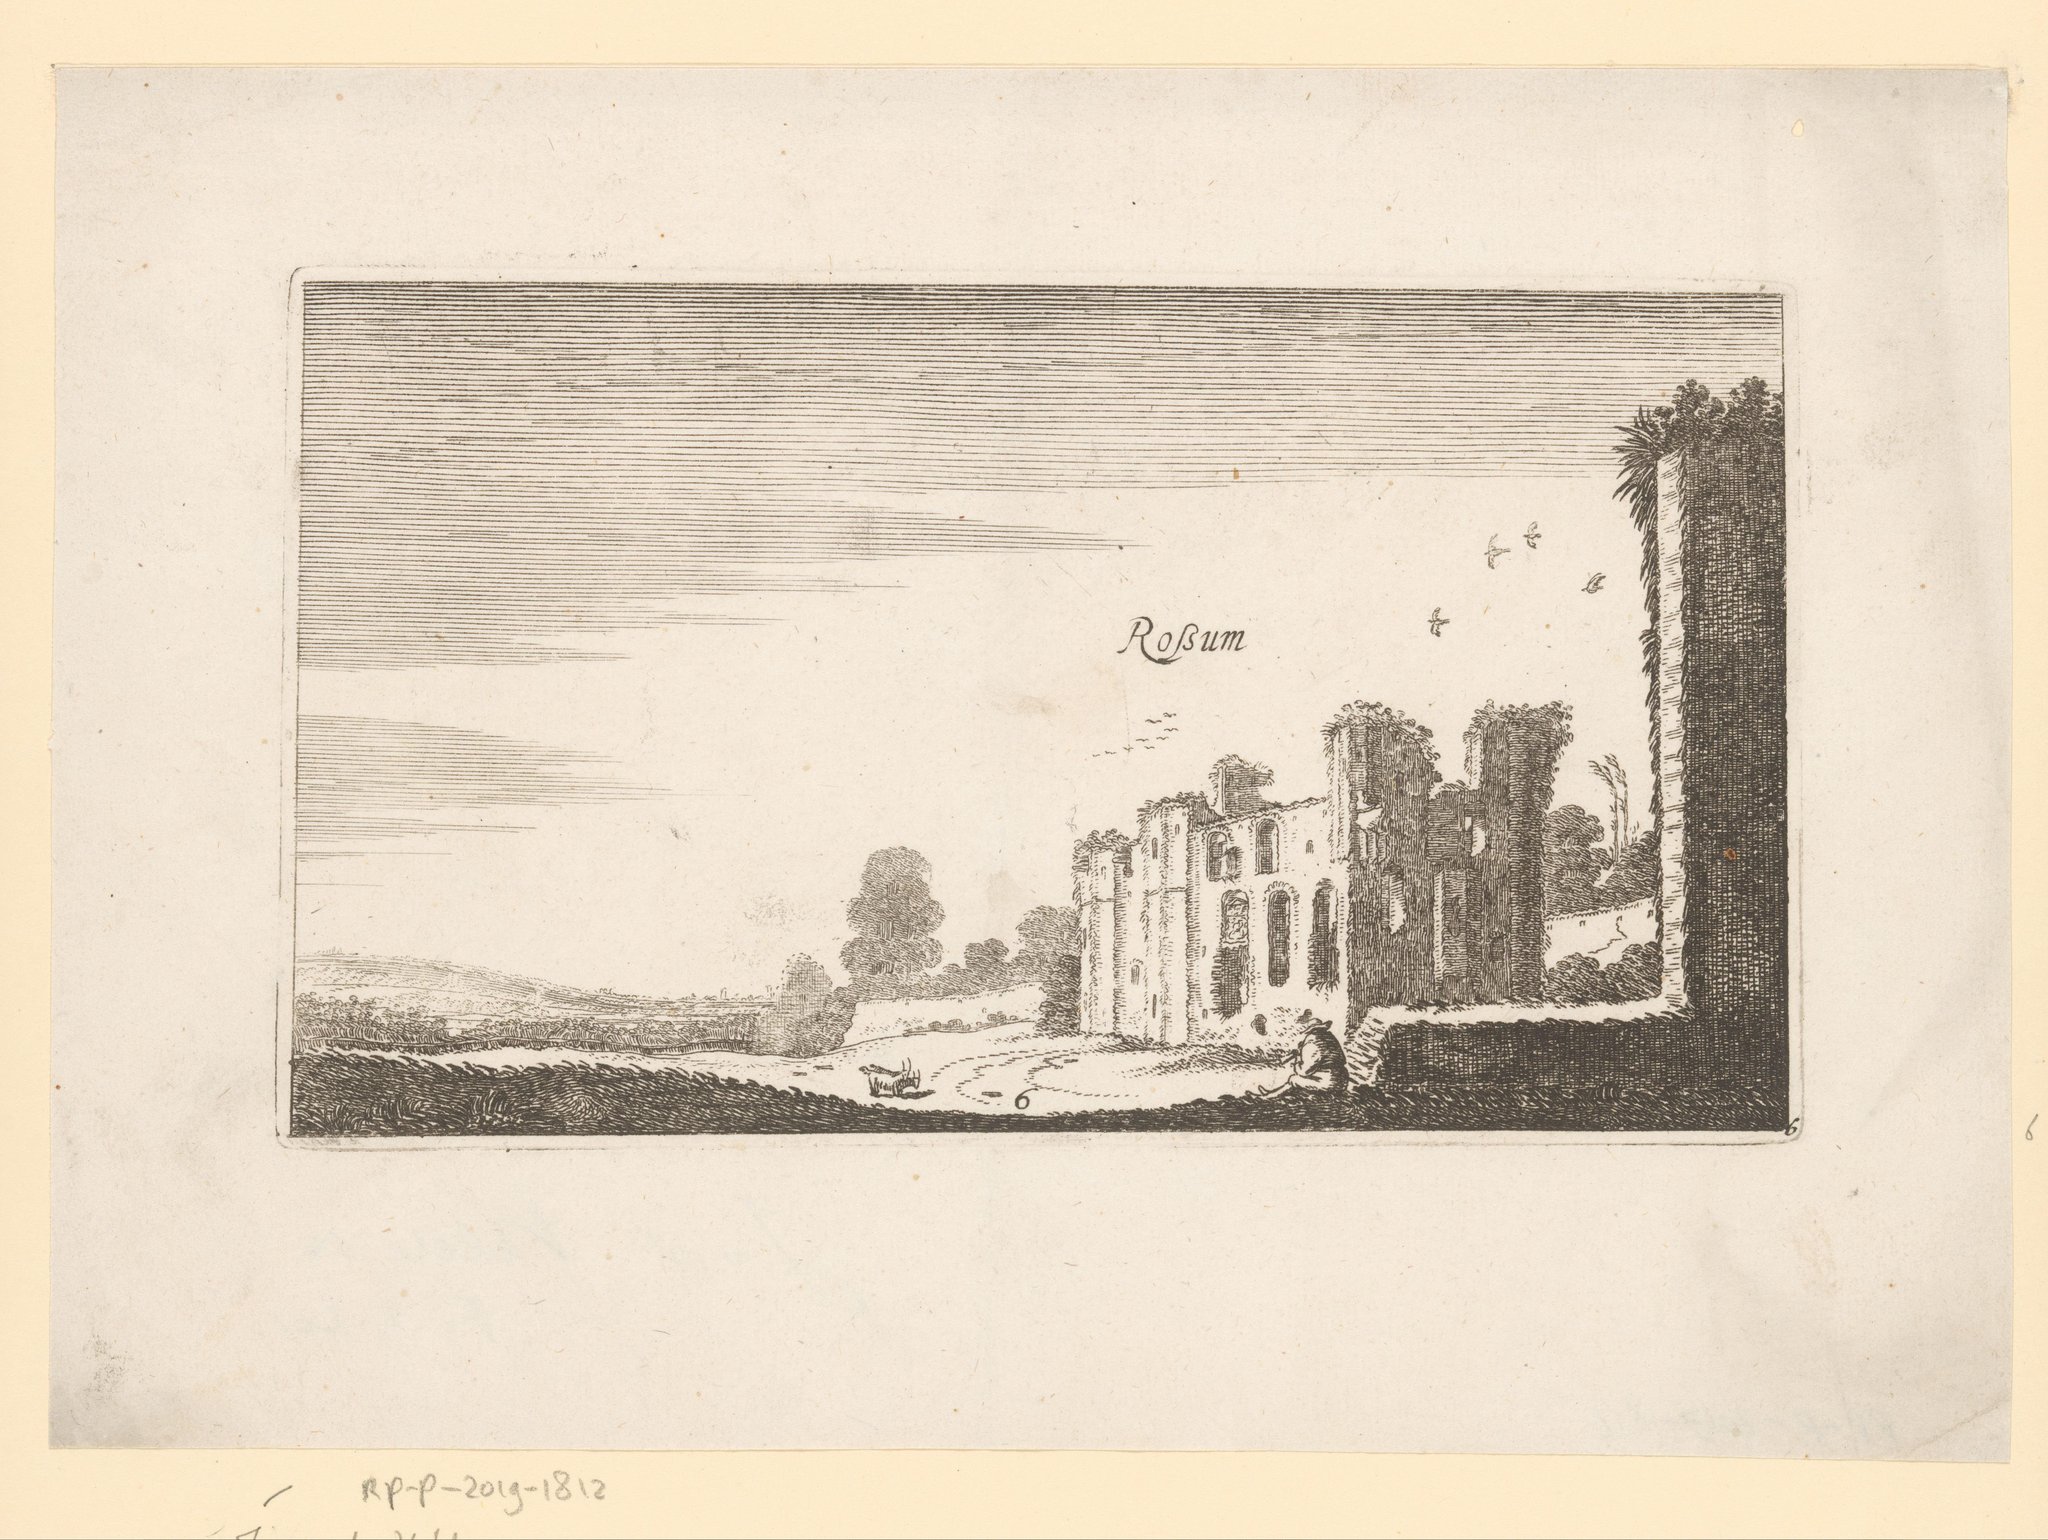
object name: print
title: Kastelen in Nederland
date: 1616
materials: paper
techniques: etching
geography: northern netherlands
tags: landscape with ruins, ruin of a dwelling, house, castle, etc.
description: Zesde prent uit een serie van zes prenten door Jan van de Velde II, uitgegeven bij Robert de Baudous in Amsterdam.